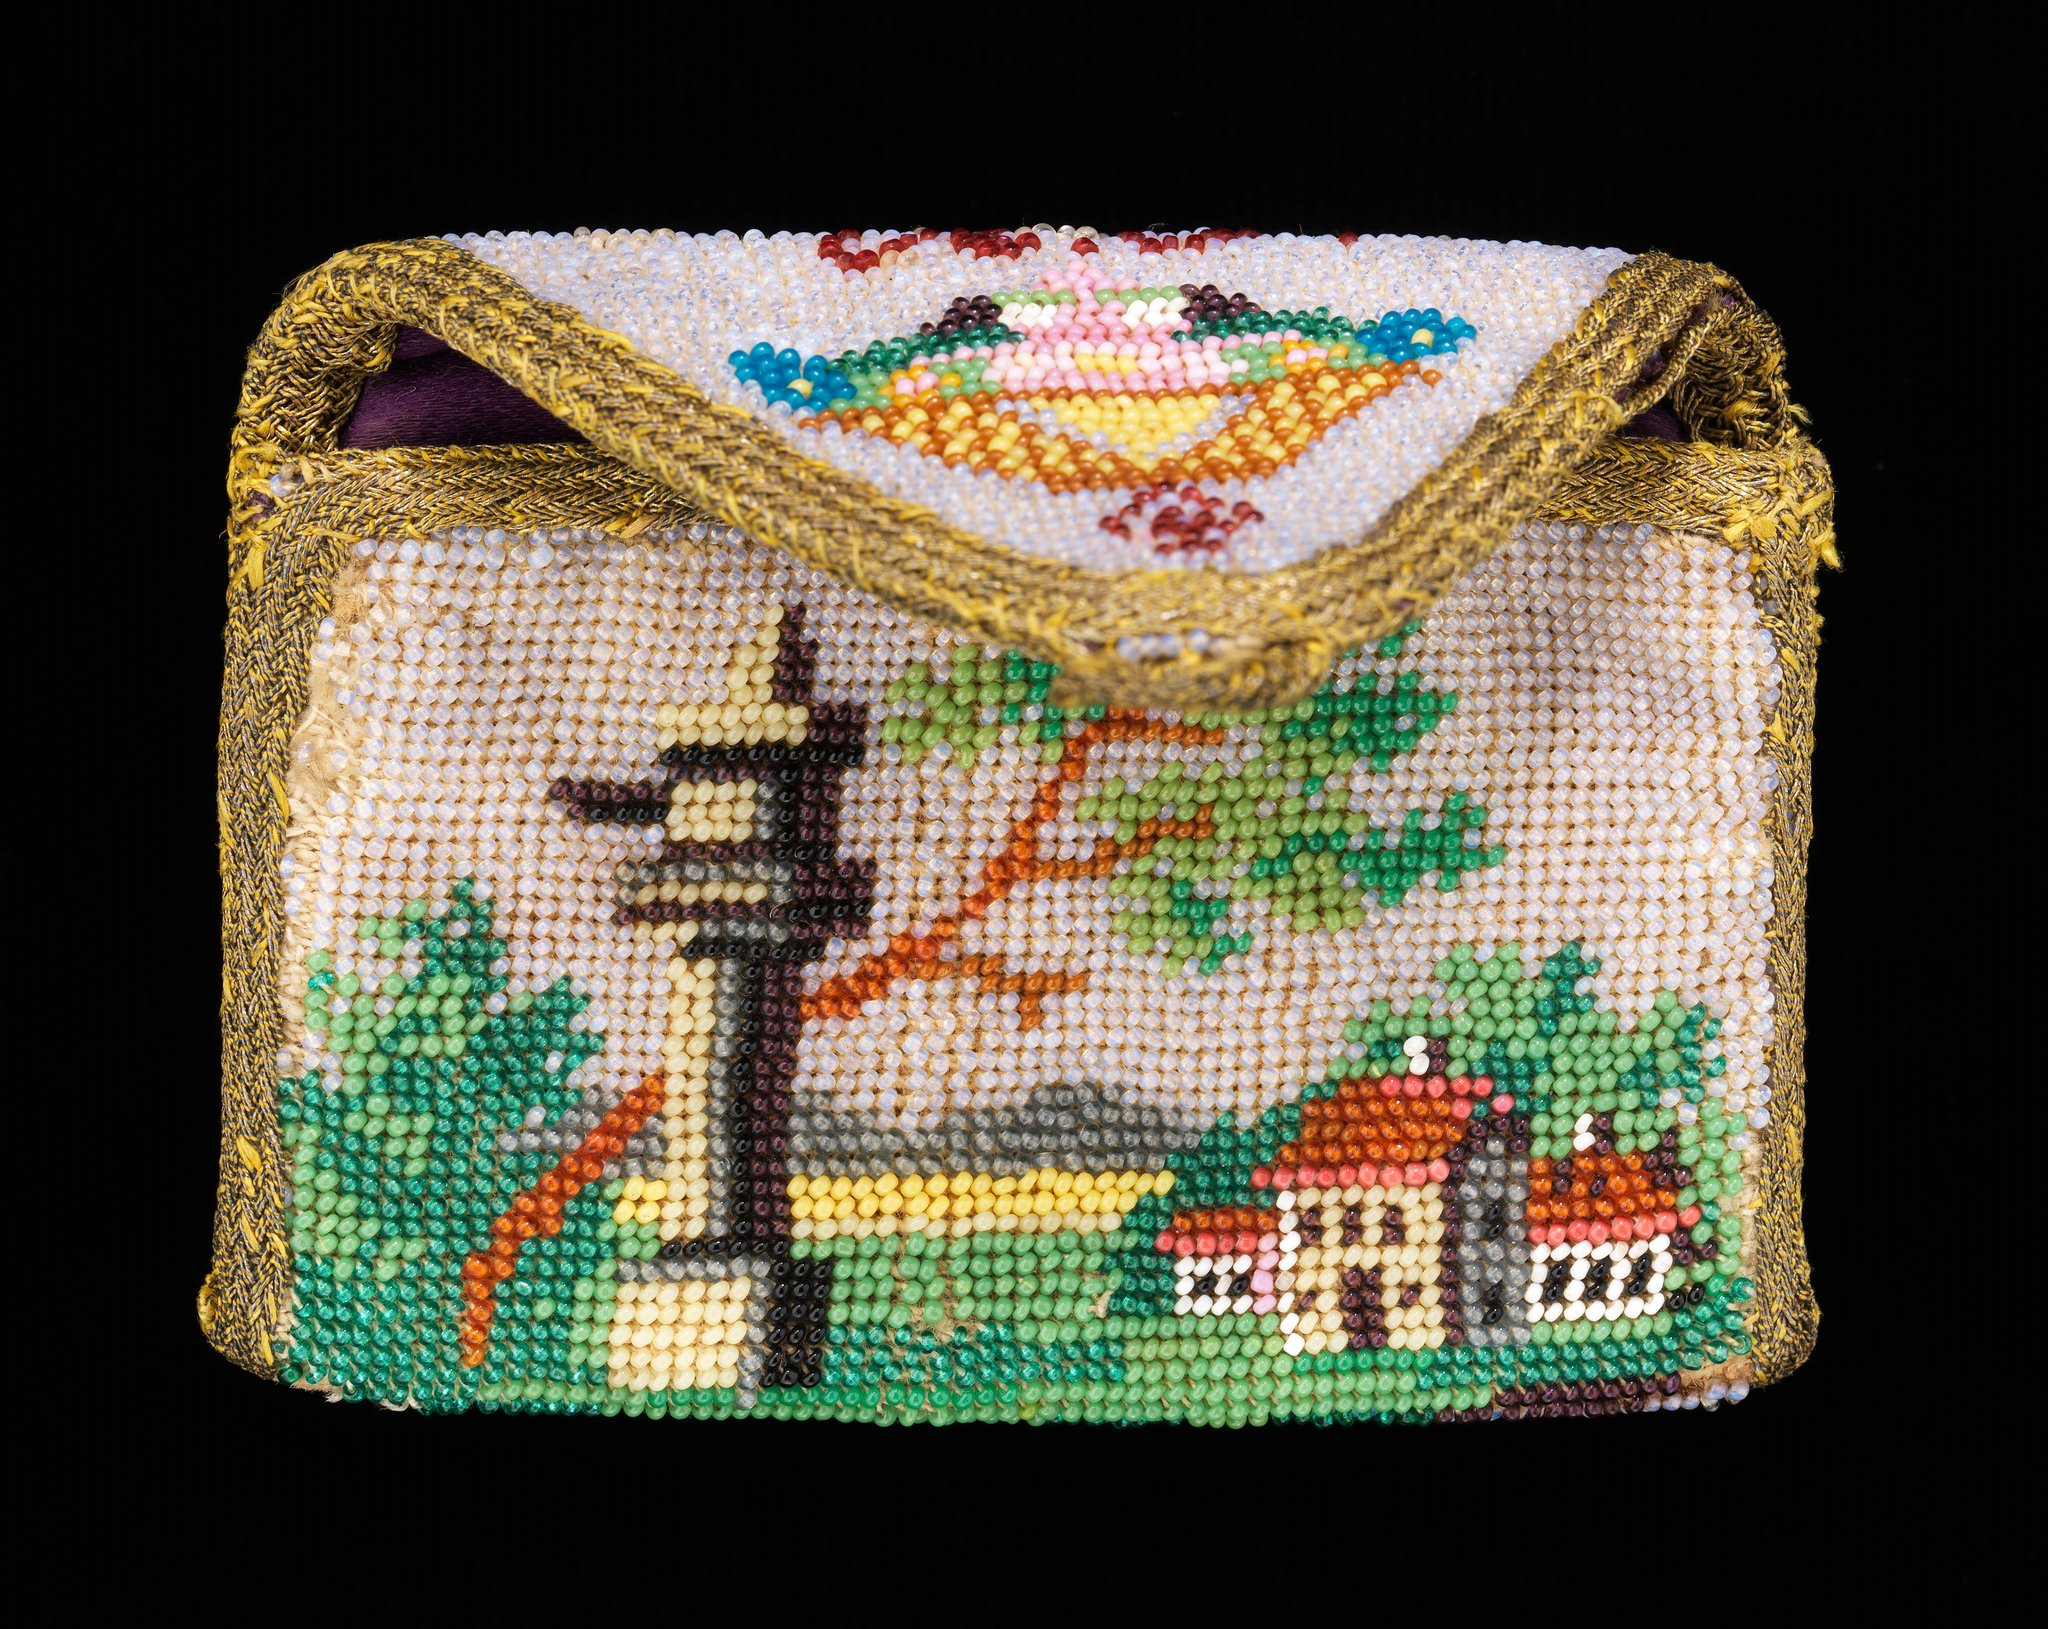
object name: coin purse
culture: mexican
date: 1800-1820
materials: glass, metal, silk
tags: landscapes